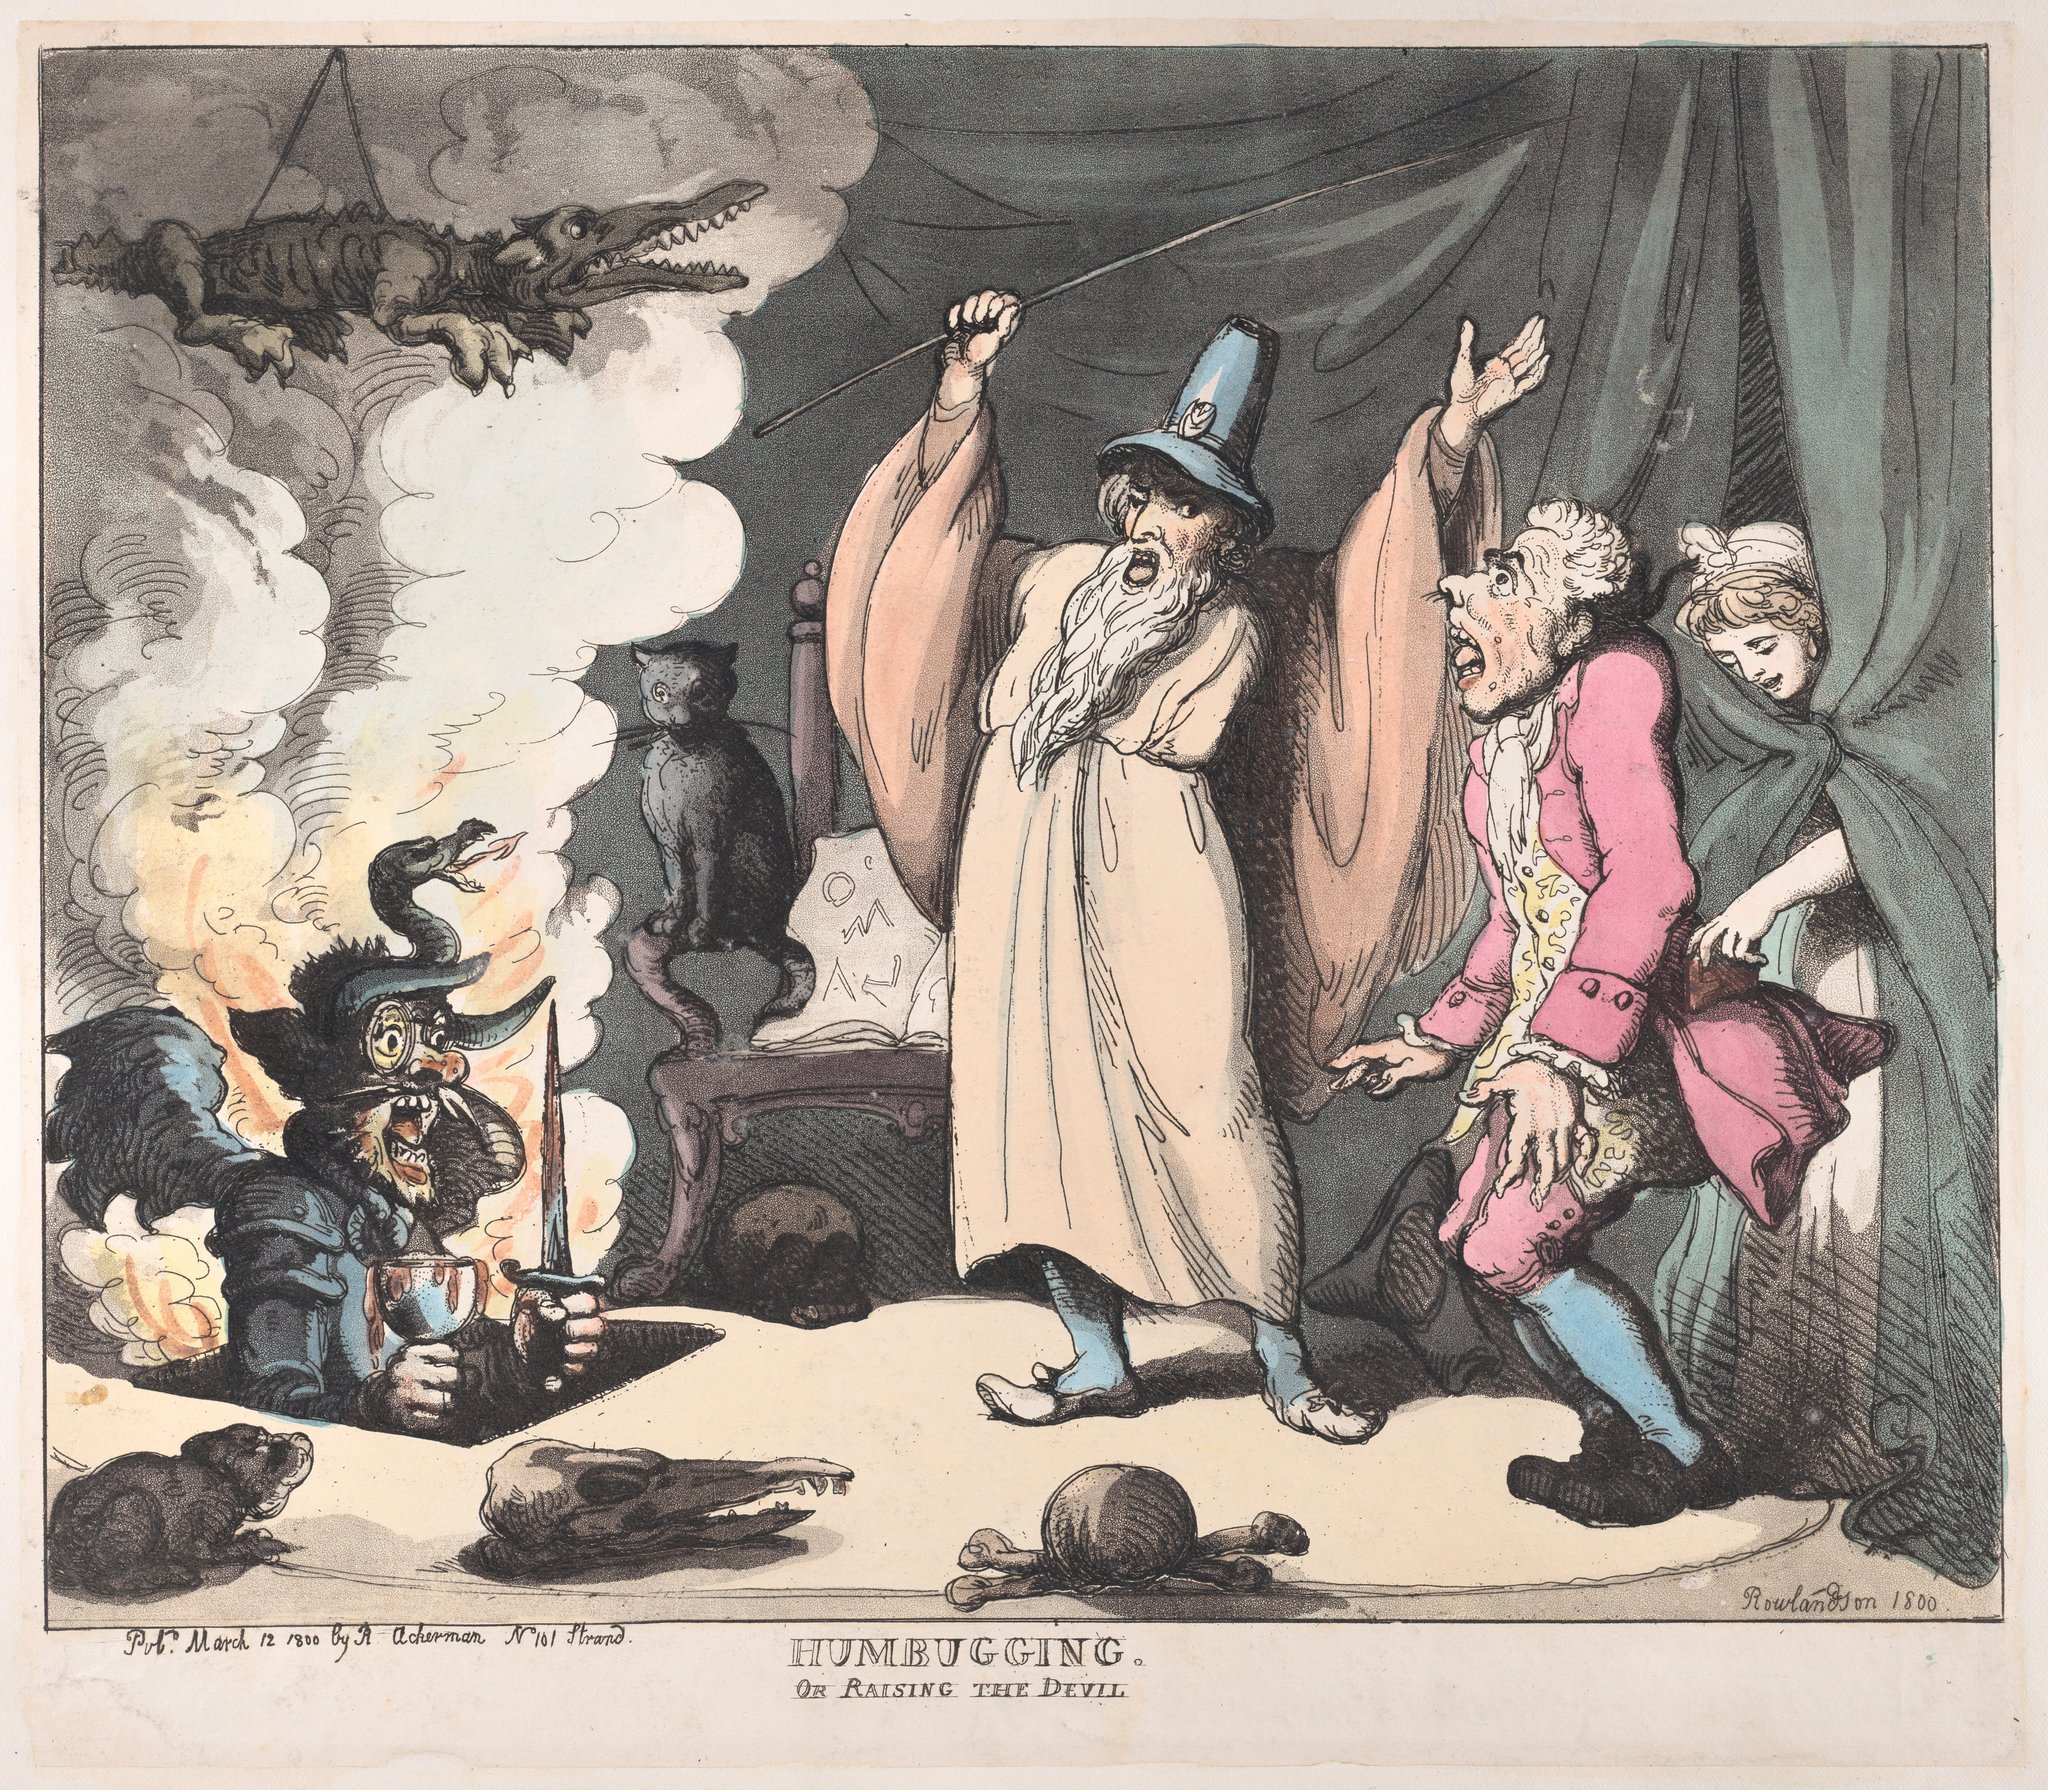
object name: print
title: Humbugging, or Raising the Devil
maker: thomas rowlandson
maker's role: artist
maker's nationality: british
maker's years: 1757-1827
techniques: aquatint, etching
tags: satire,men,women,cats,crocodiles